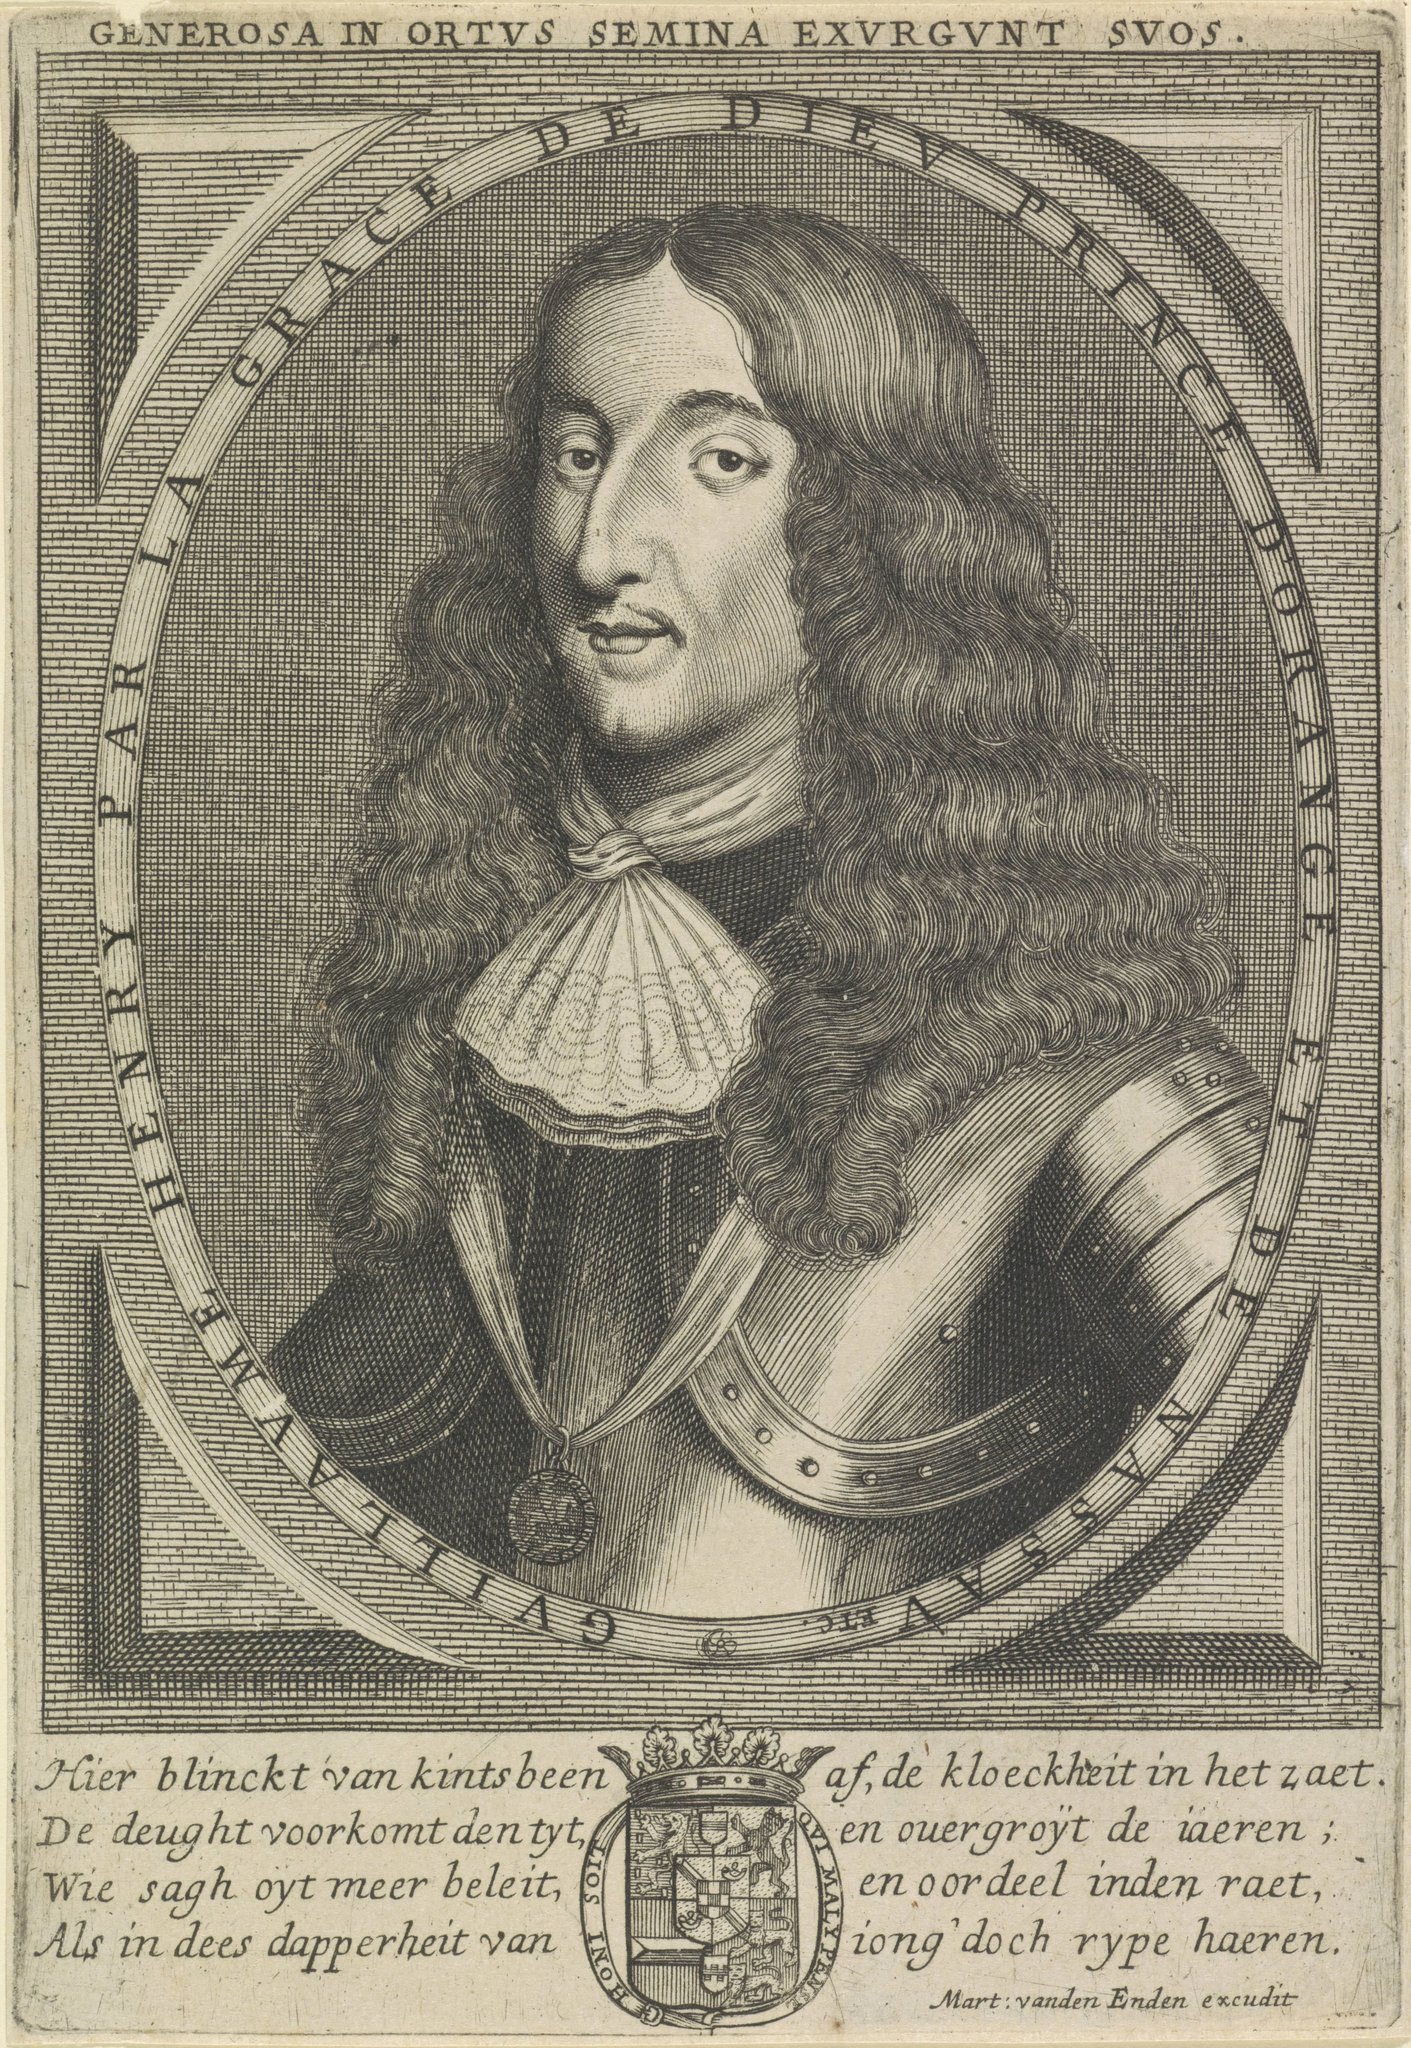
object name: print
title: Portret van Willem III, prins van Oranje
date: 1670-1674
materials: paper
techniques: engraving, etching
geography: antwerp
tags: william iii (prince of orange and king of england, scotland, and ireland), knighthood order (garter) - insignia of a knighthood order, e.g.: badge, chain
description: Portret van Willem III in een ovaal met randschrift in het Frans. Midden onder zijn wapen met een kroon, gedecoreerd met de Kousenband en het devies van de Orde van de Kousenband. In de bovenmarge een regel Latijnse tekst. In de ondermarge vier regels Nederlandse tekst.